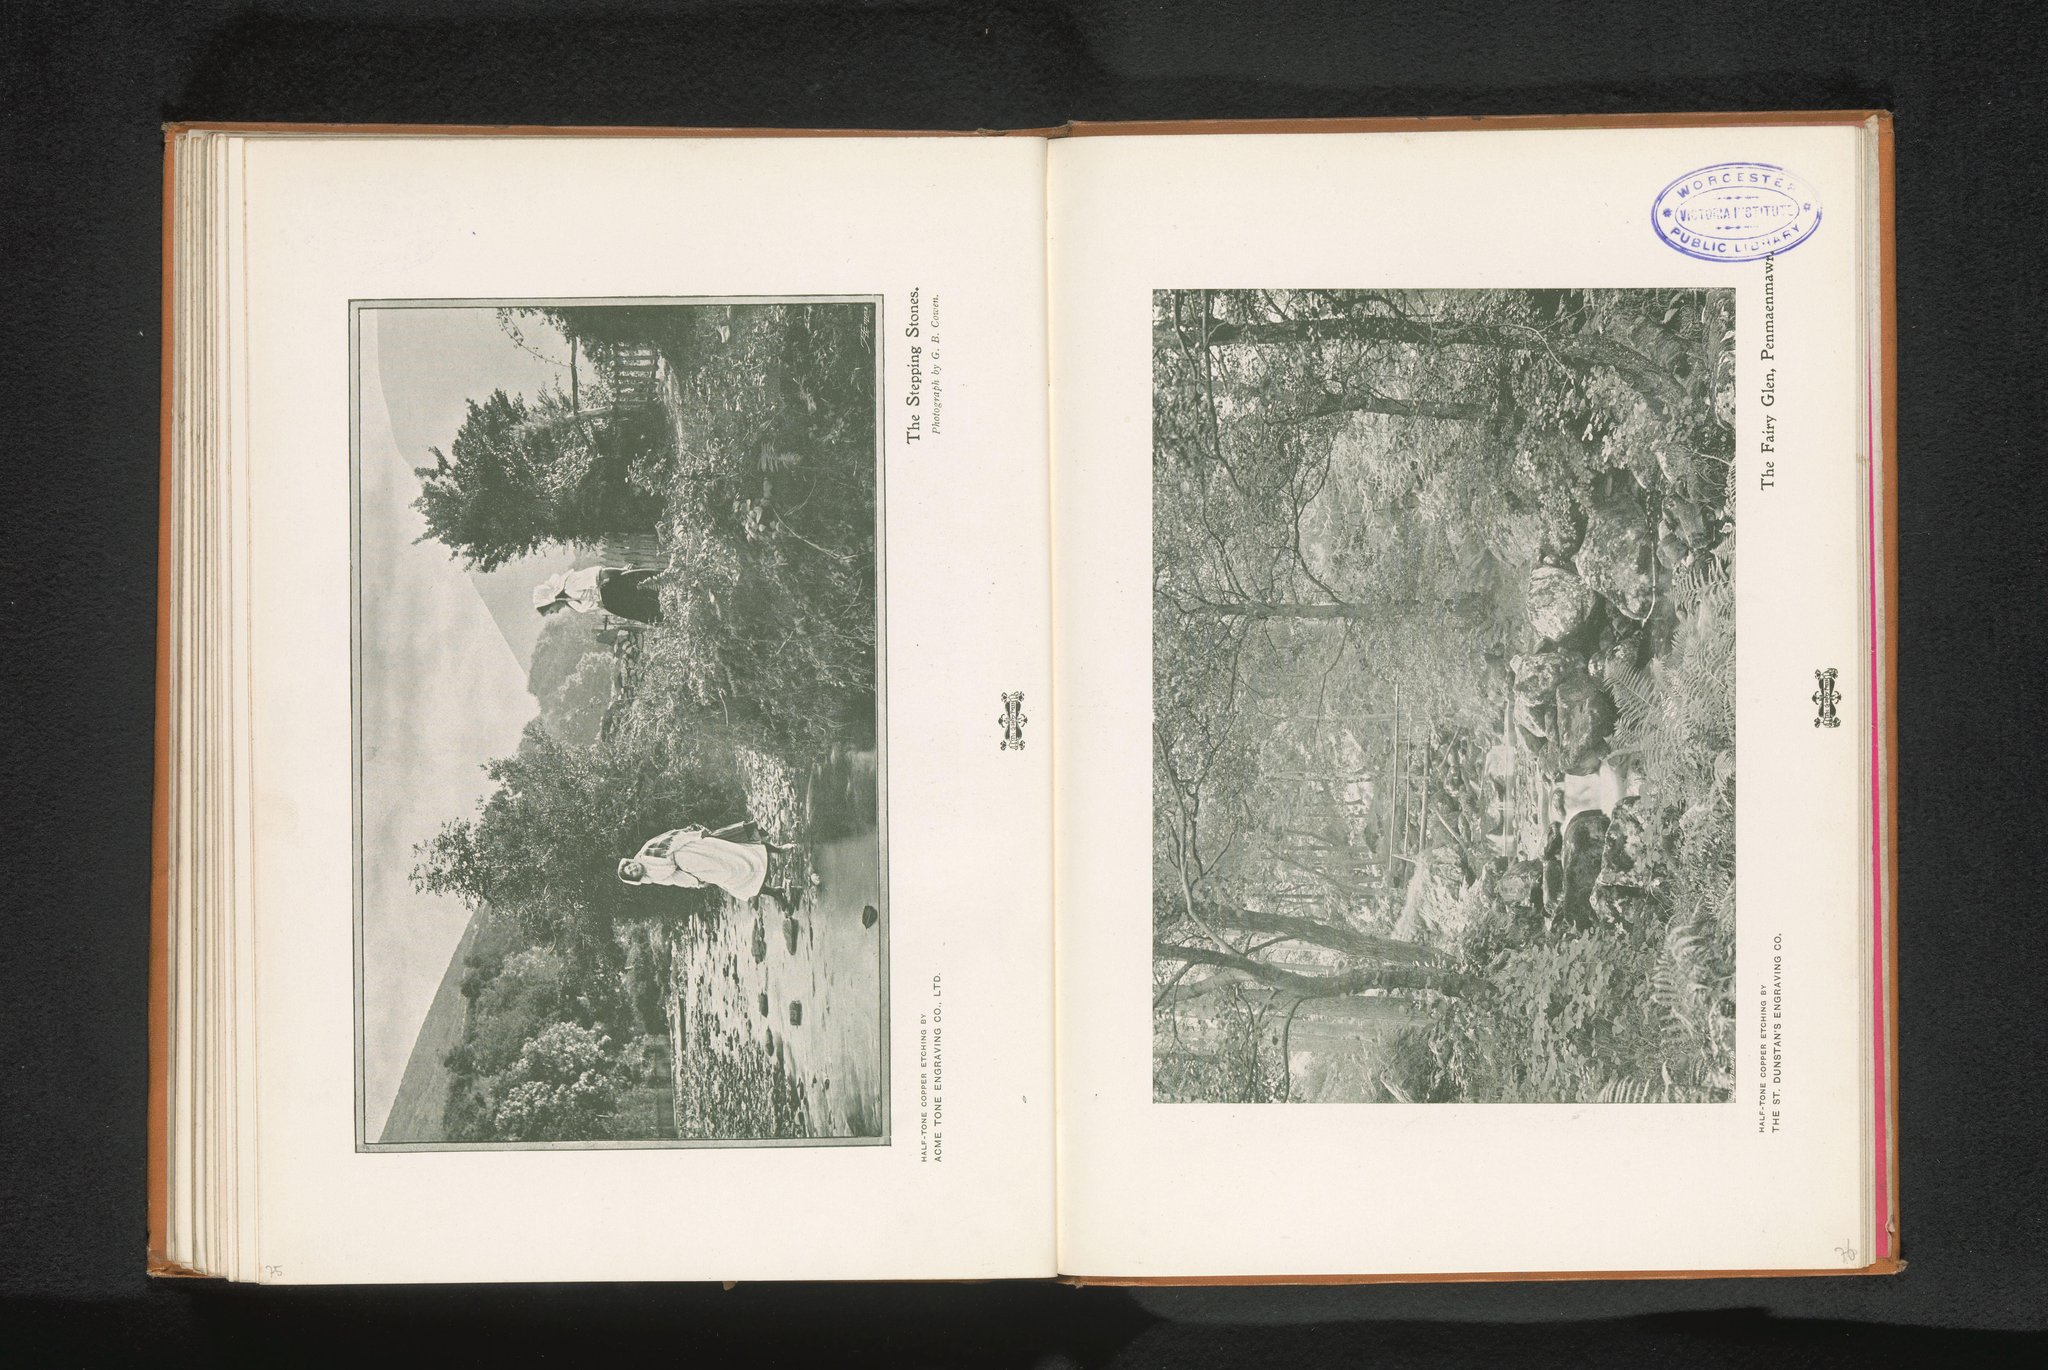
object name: photomechanical print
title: The Fairy Glen, Penmaenmawr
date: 1894-1899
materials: paper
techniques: autotype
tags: forest, wood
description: Prent op derde ongenummerde pagina na pagina 104.